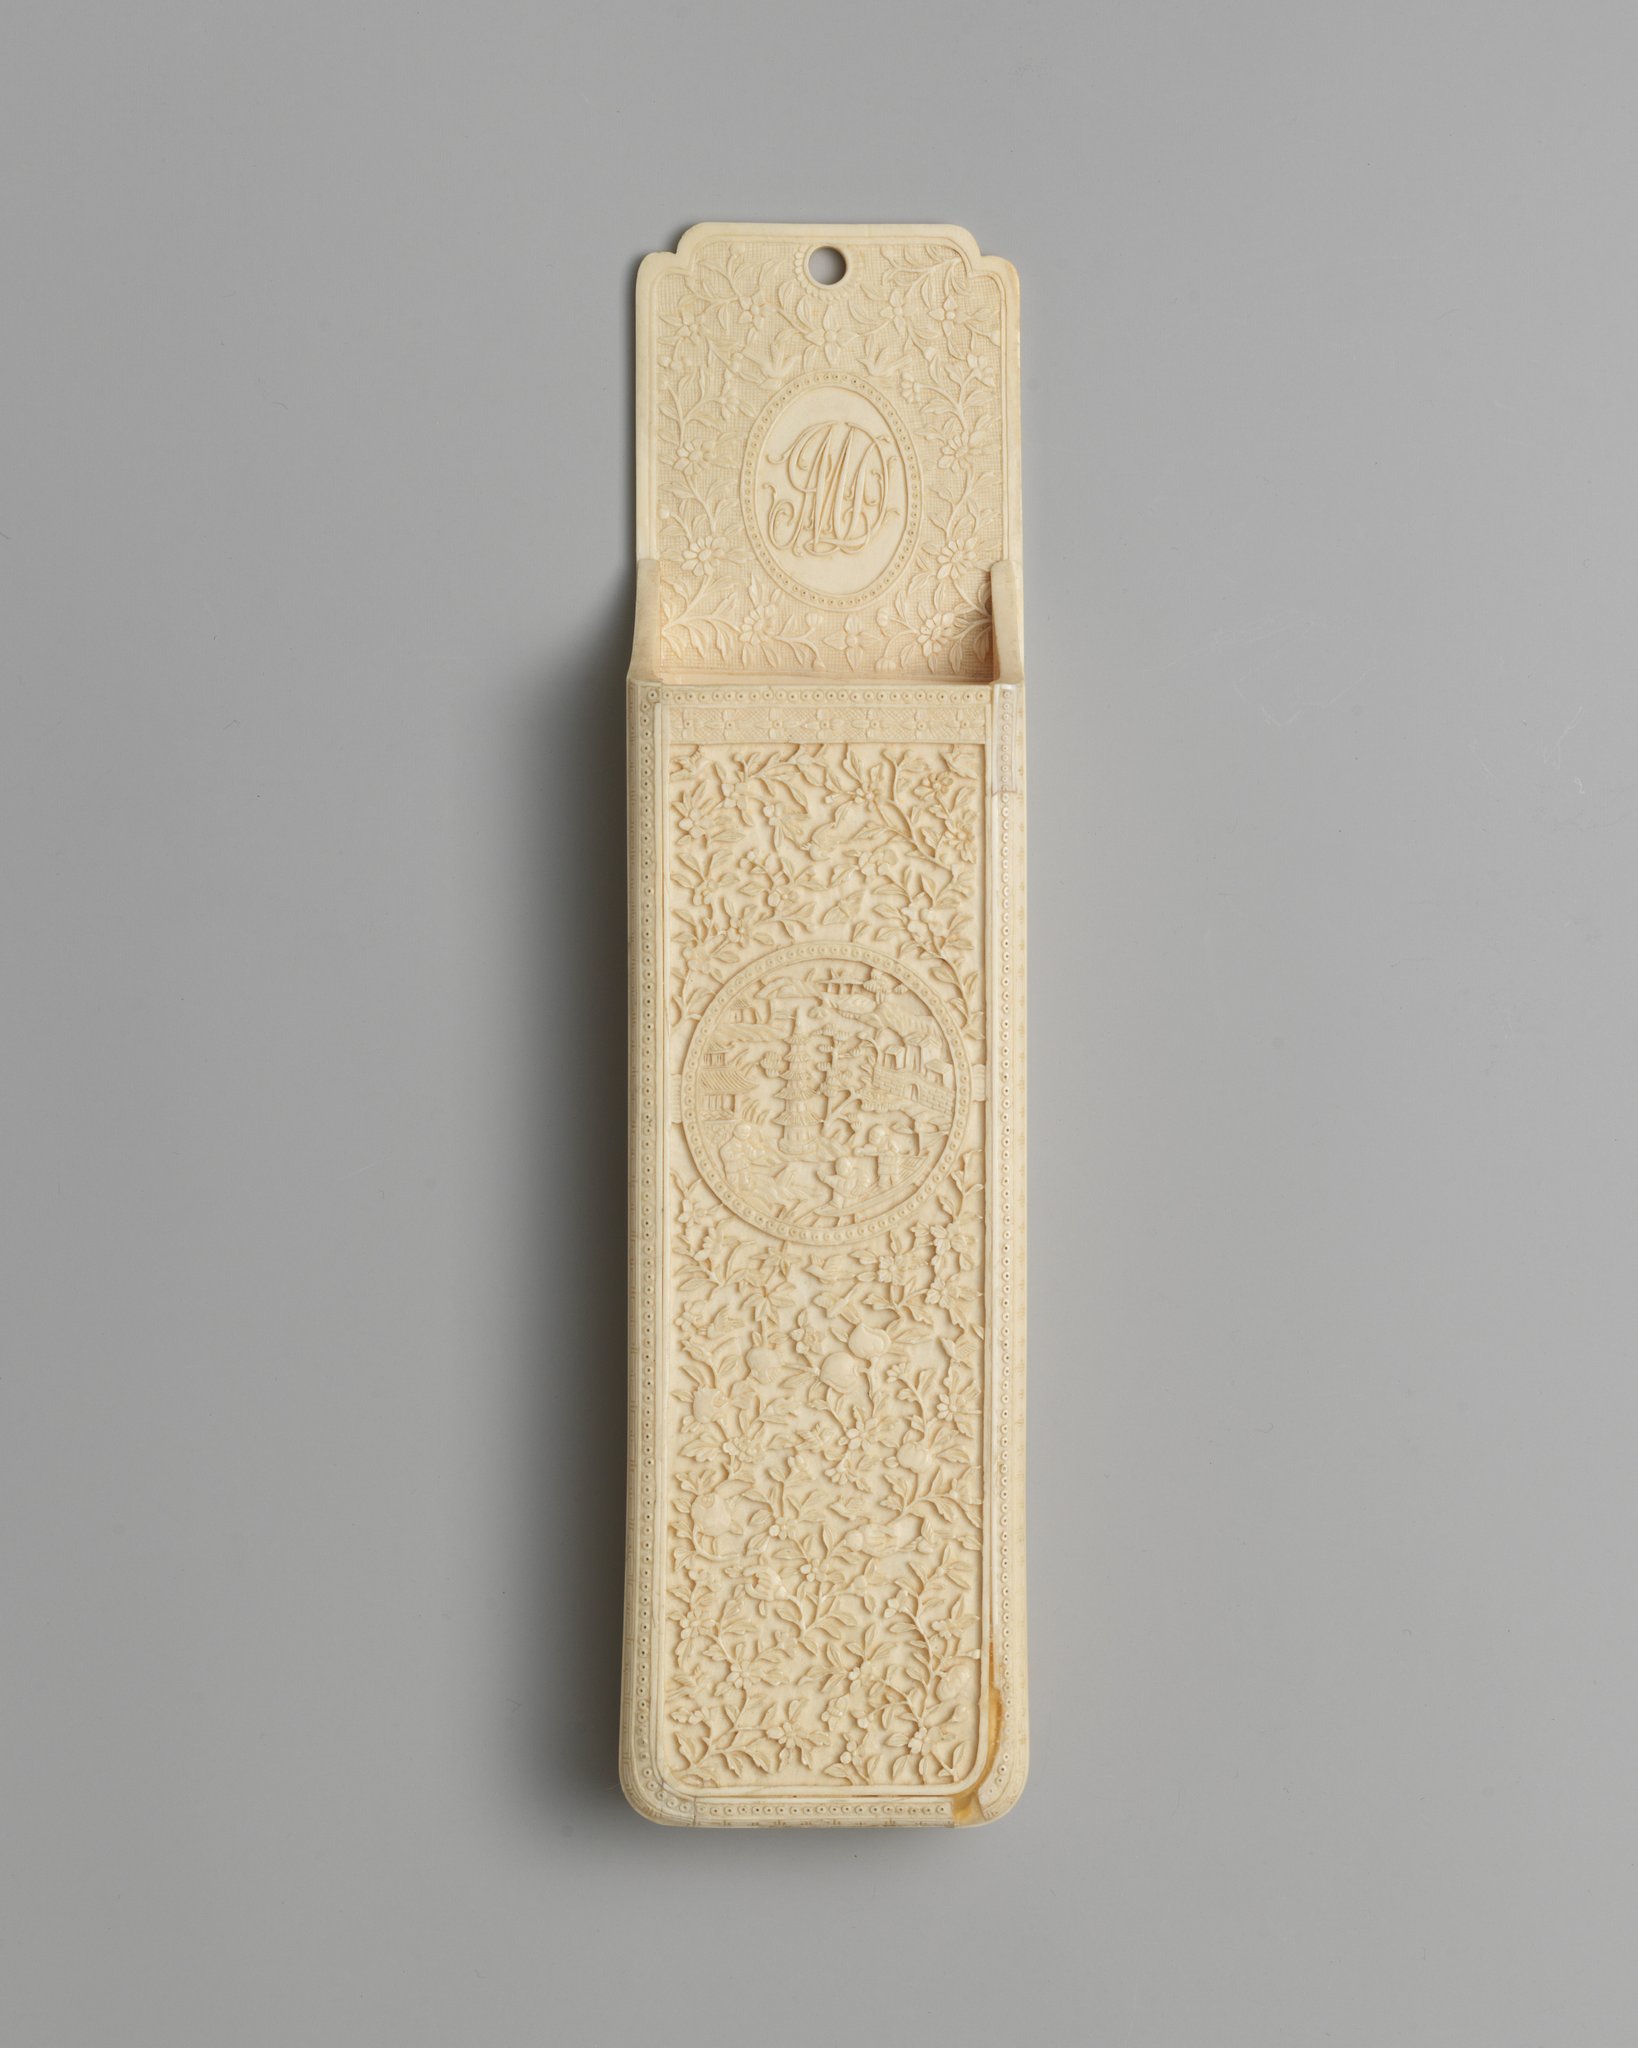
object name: fan box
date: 1801-1900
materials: ivory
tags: flowers,leaves,insignia